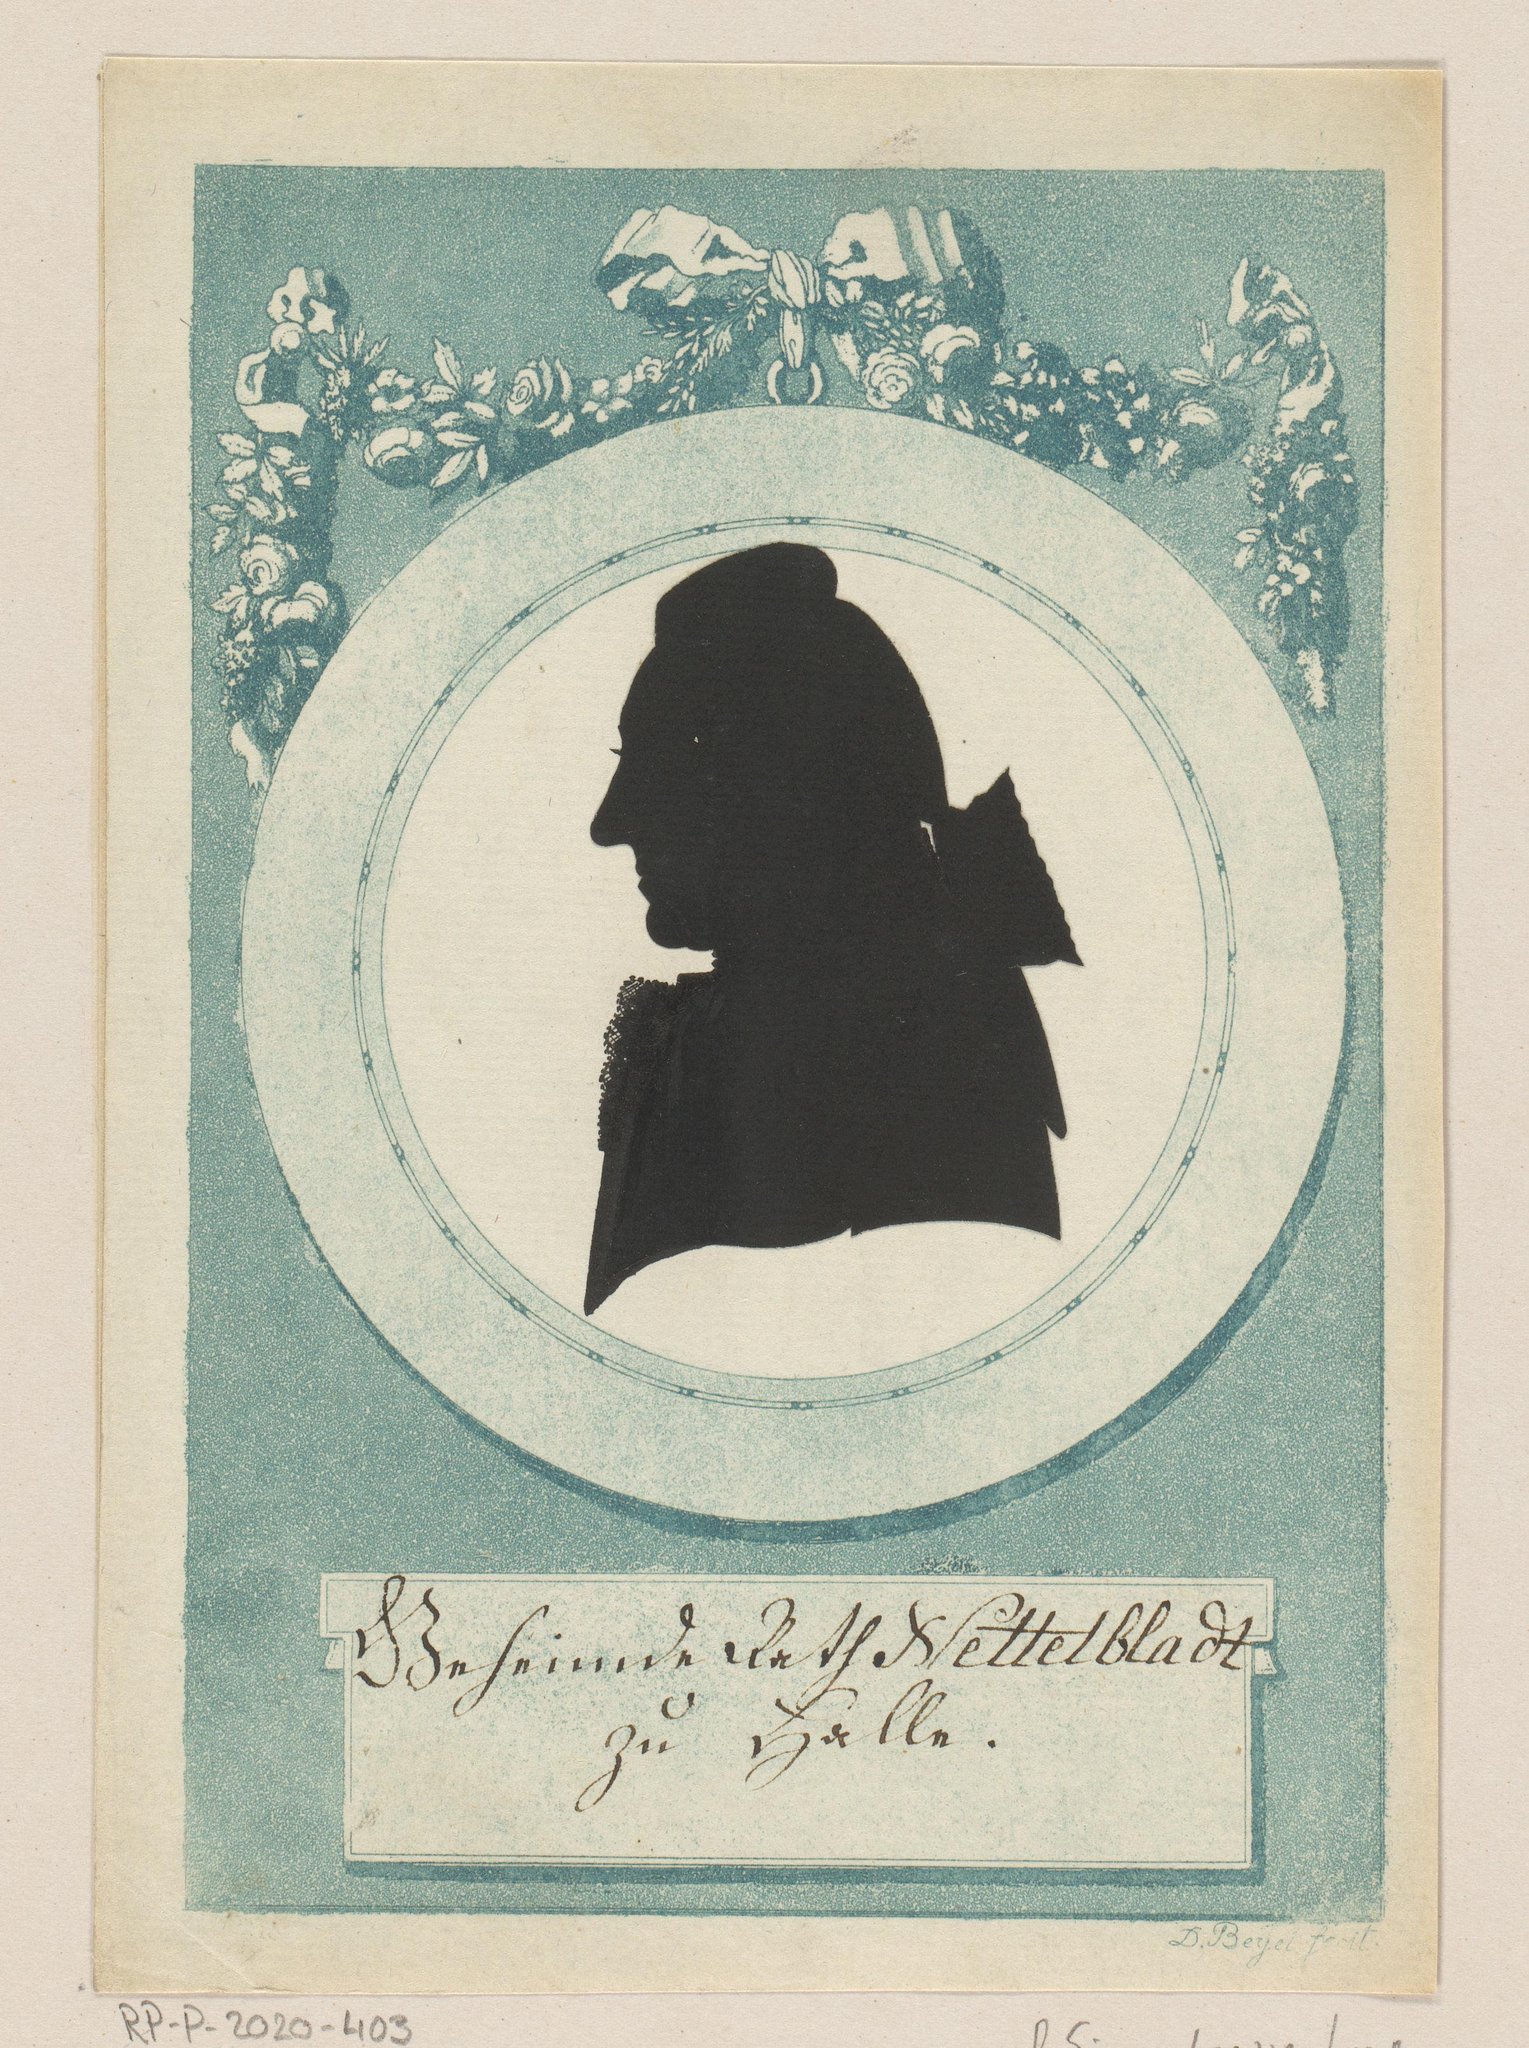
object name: cut paper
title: Silhouetportret van Daniel Nettelbladt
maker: daniel beyel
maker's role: draughtsman, print maker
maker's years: 1760-1823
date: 1750-1799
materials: ink, paper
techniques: aquatint, etching, pen, snipping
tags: halle, historical persons